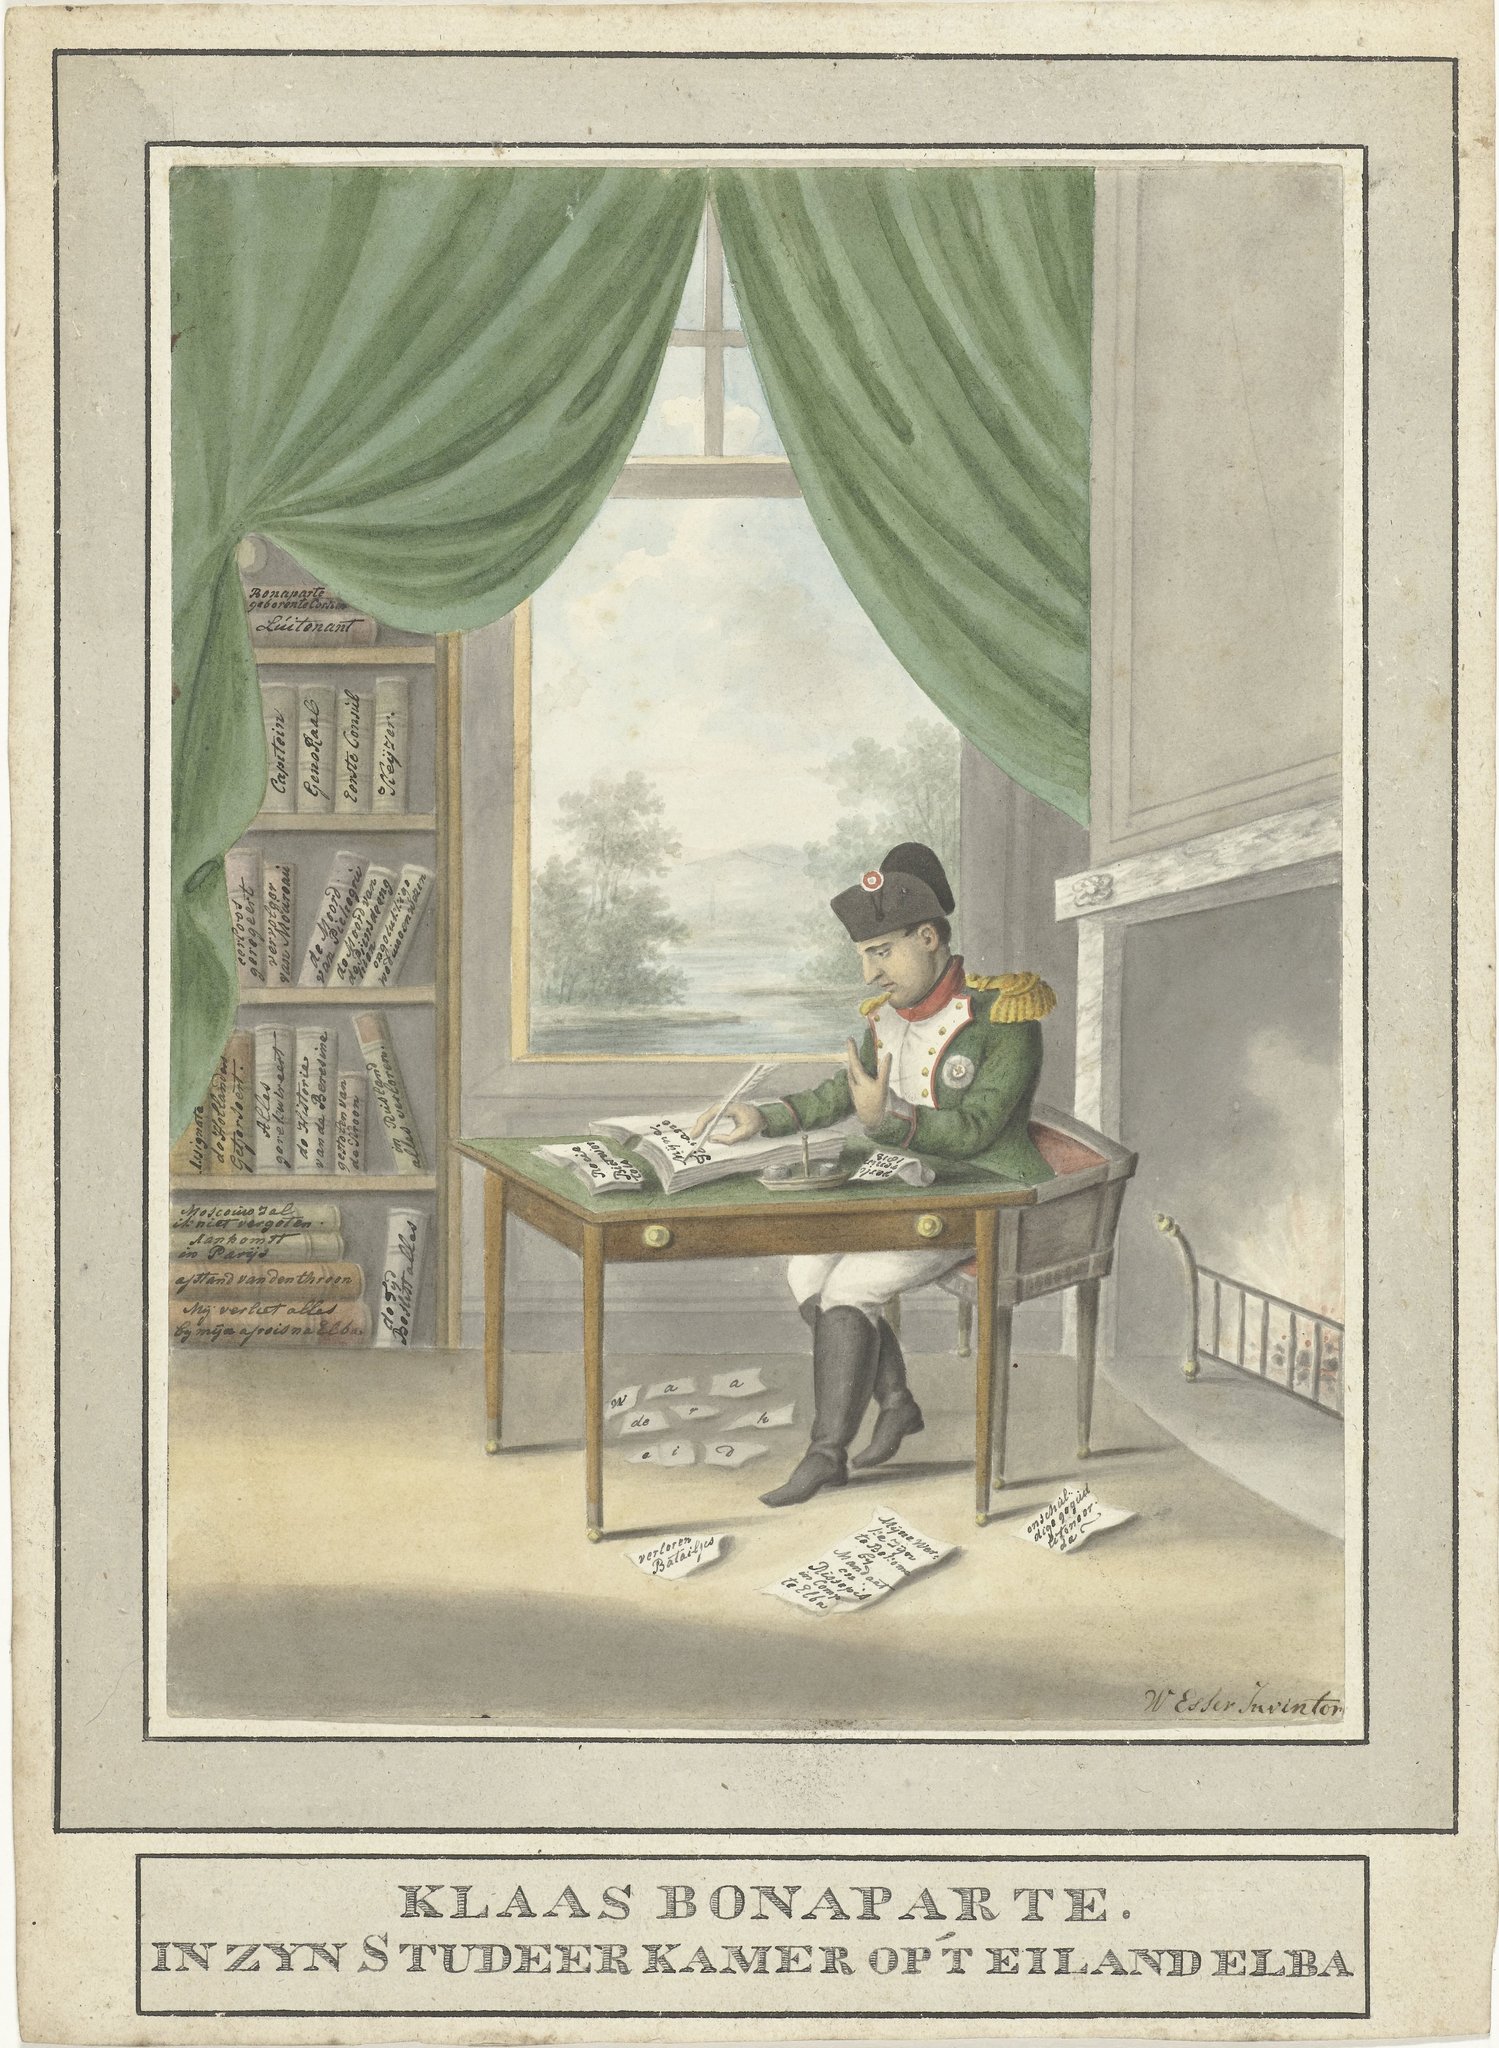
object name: drawing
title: Spotprent op Napoleon: Klaas Bonaparte in zijn studeervertrek op 't eiland Elba, 1814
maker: wijnand esser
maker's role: draughtsman, print maker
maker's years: 1779-1860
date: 1814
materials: ink, paper, pencil, watercolor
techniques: brush, pen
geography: netherlands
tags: napoleon i (emperor of the french), historical persons, writing and letters, political caricatures and satires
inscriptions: inscription: ‘Klaas Bonaparte in zijn studeervertrek op 't eiland Elba’